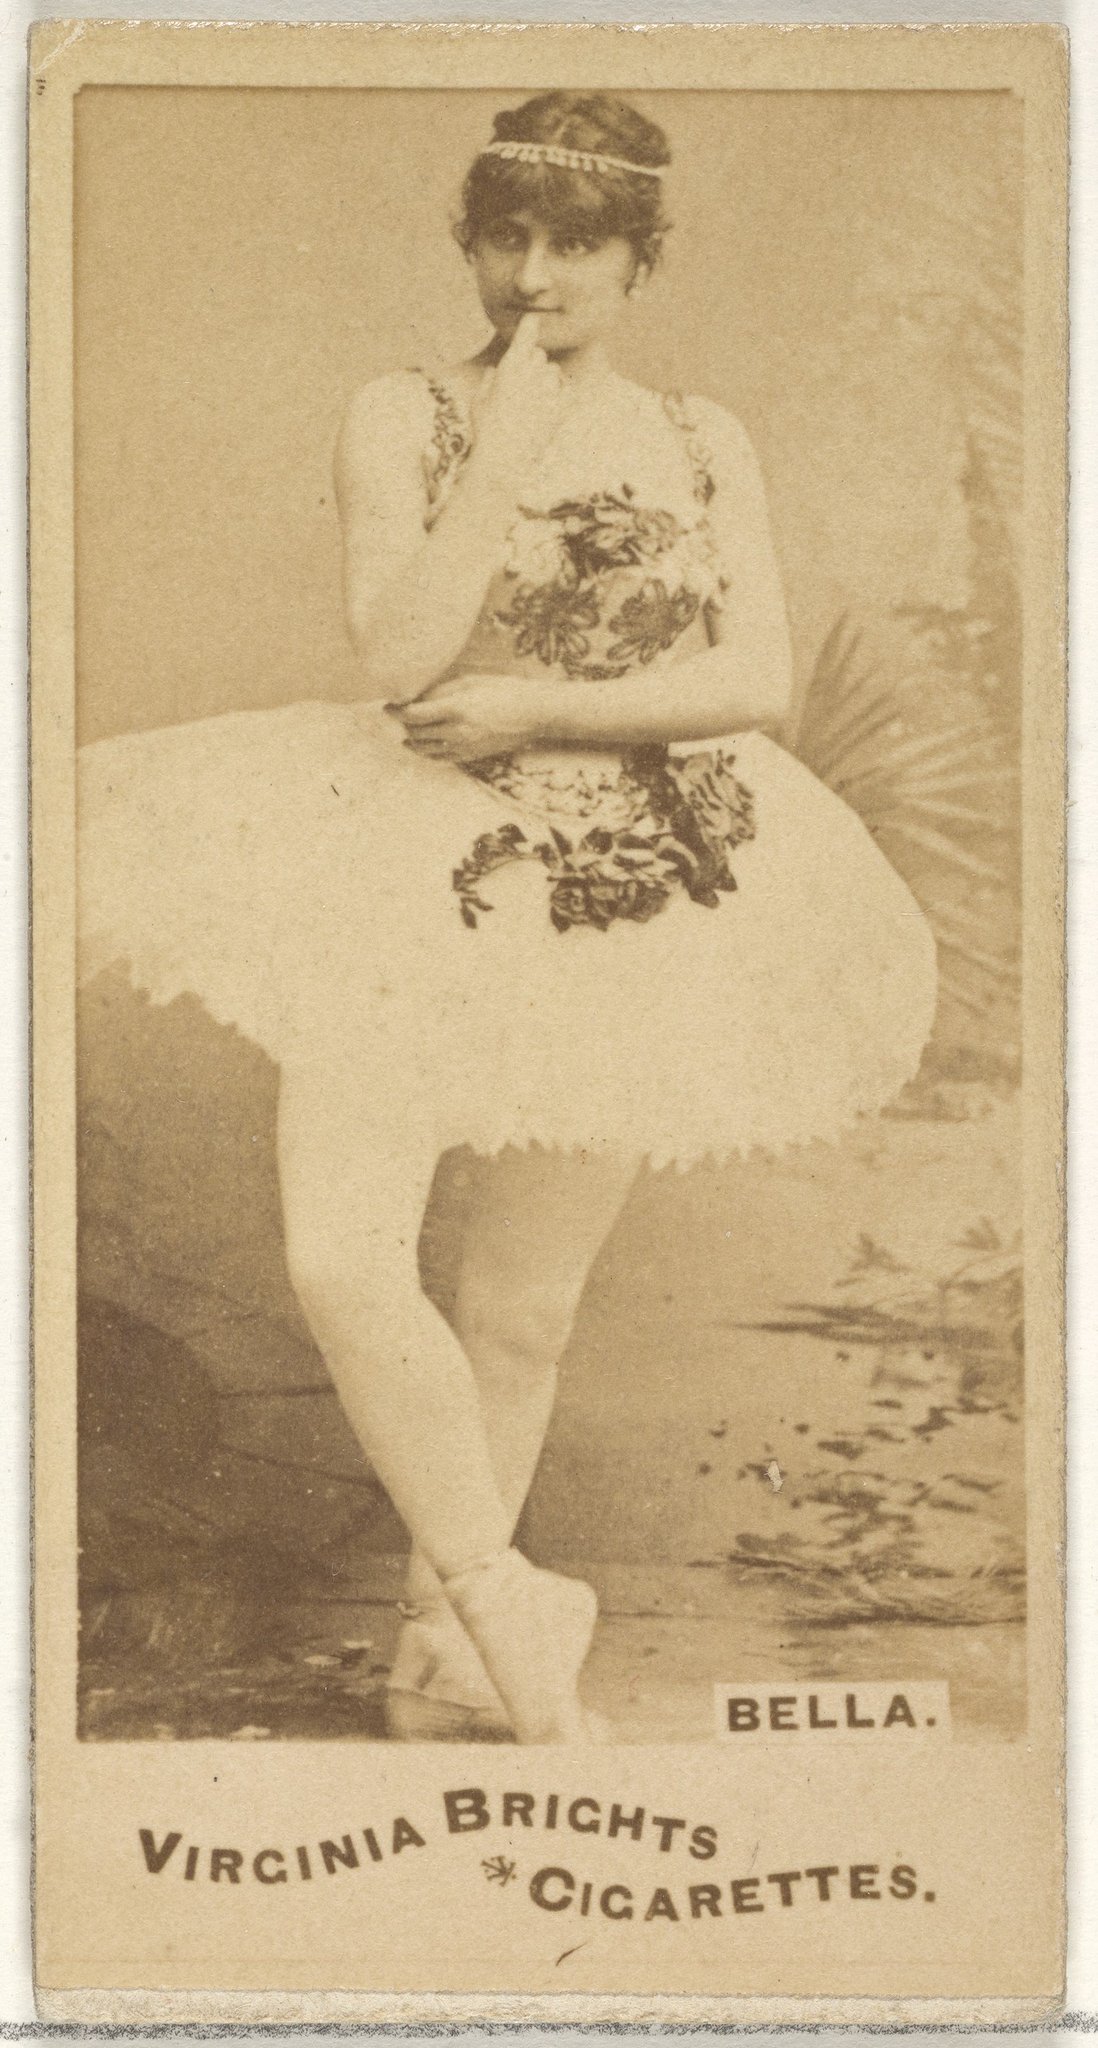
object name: photograph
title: Bella, from the Actors and Actresses series (N45, Type 1) for Virginia Brights Cigarettes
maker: allen & ginter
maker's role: publisher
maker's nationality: american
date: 1888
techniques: albumen silver print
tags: portraits,women,dancers,ballet